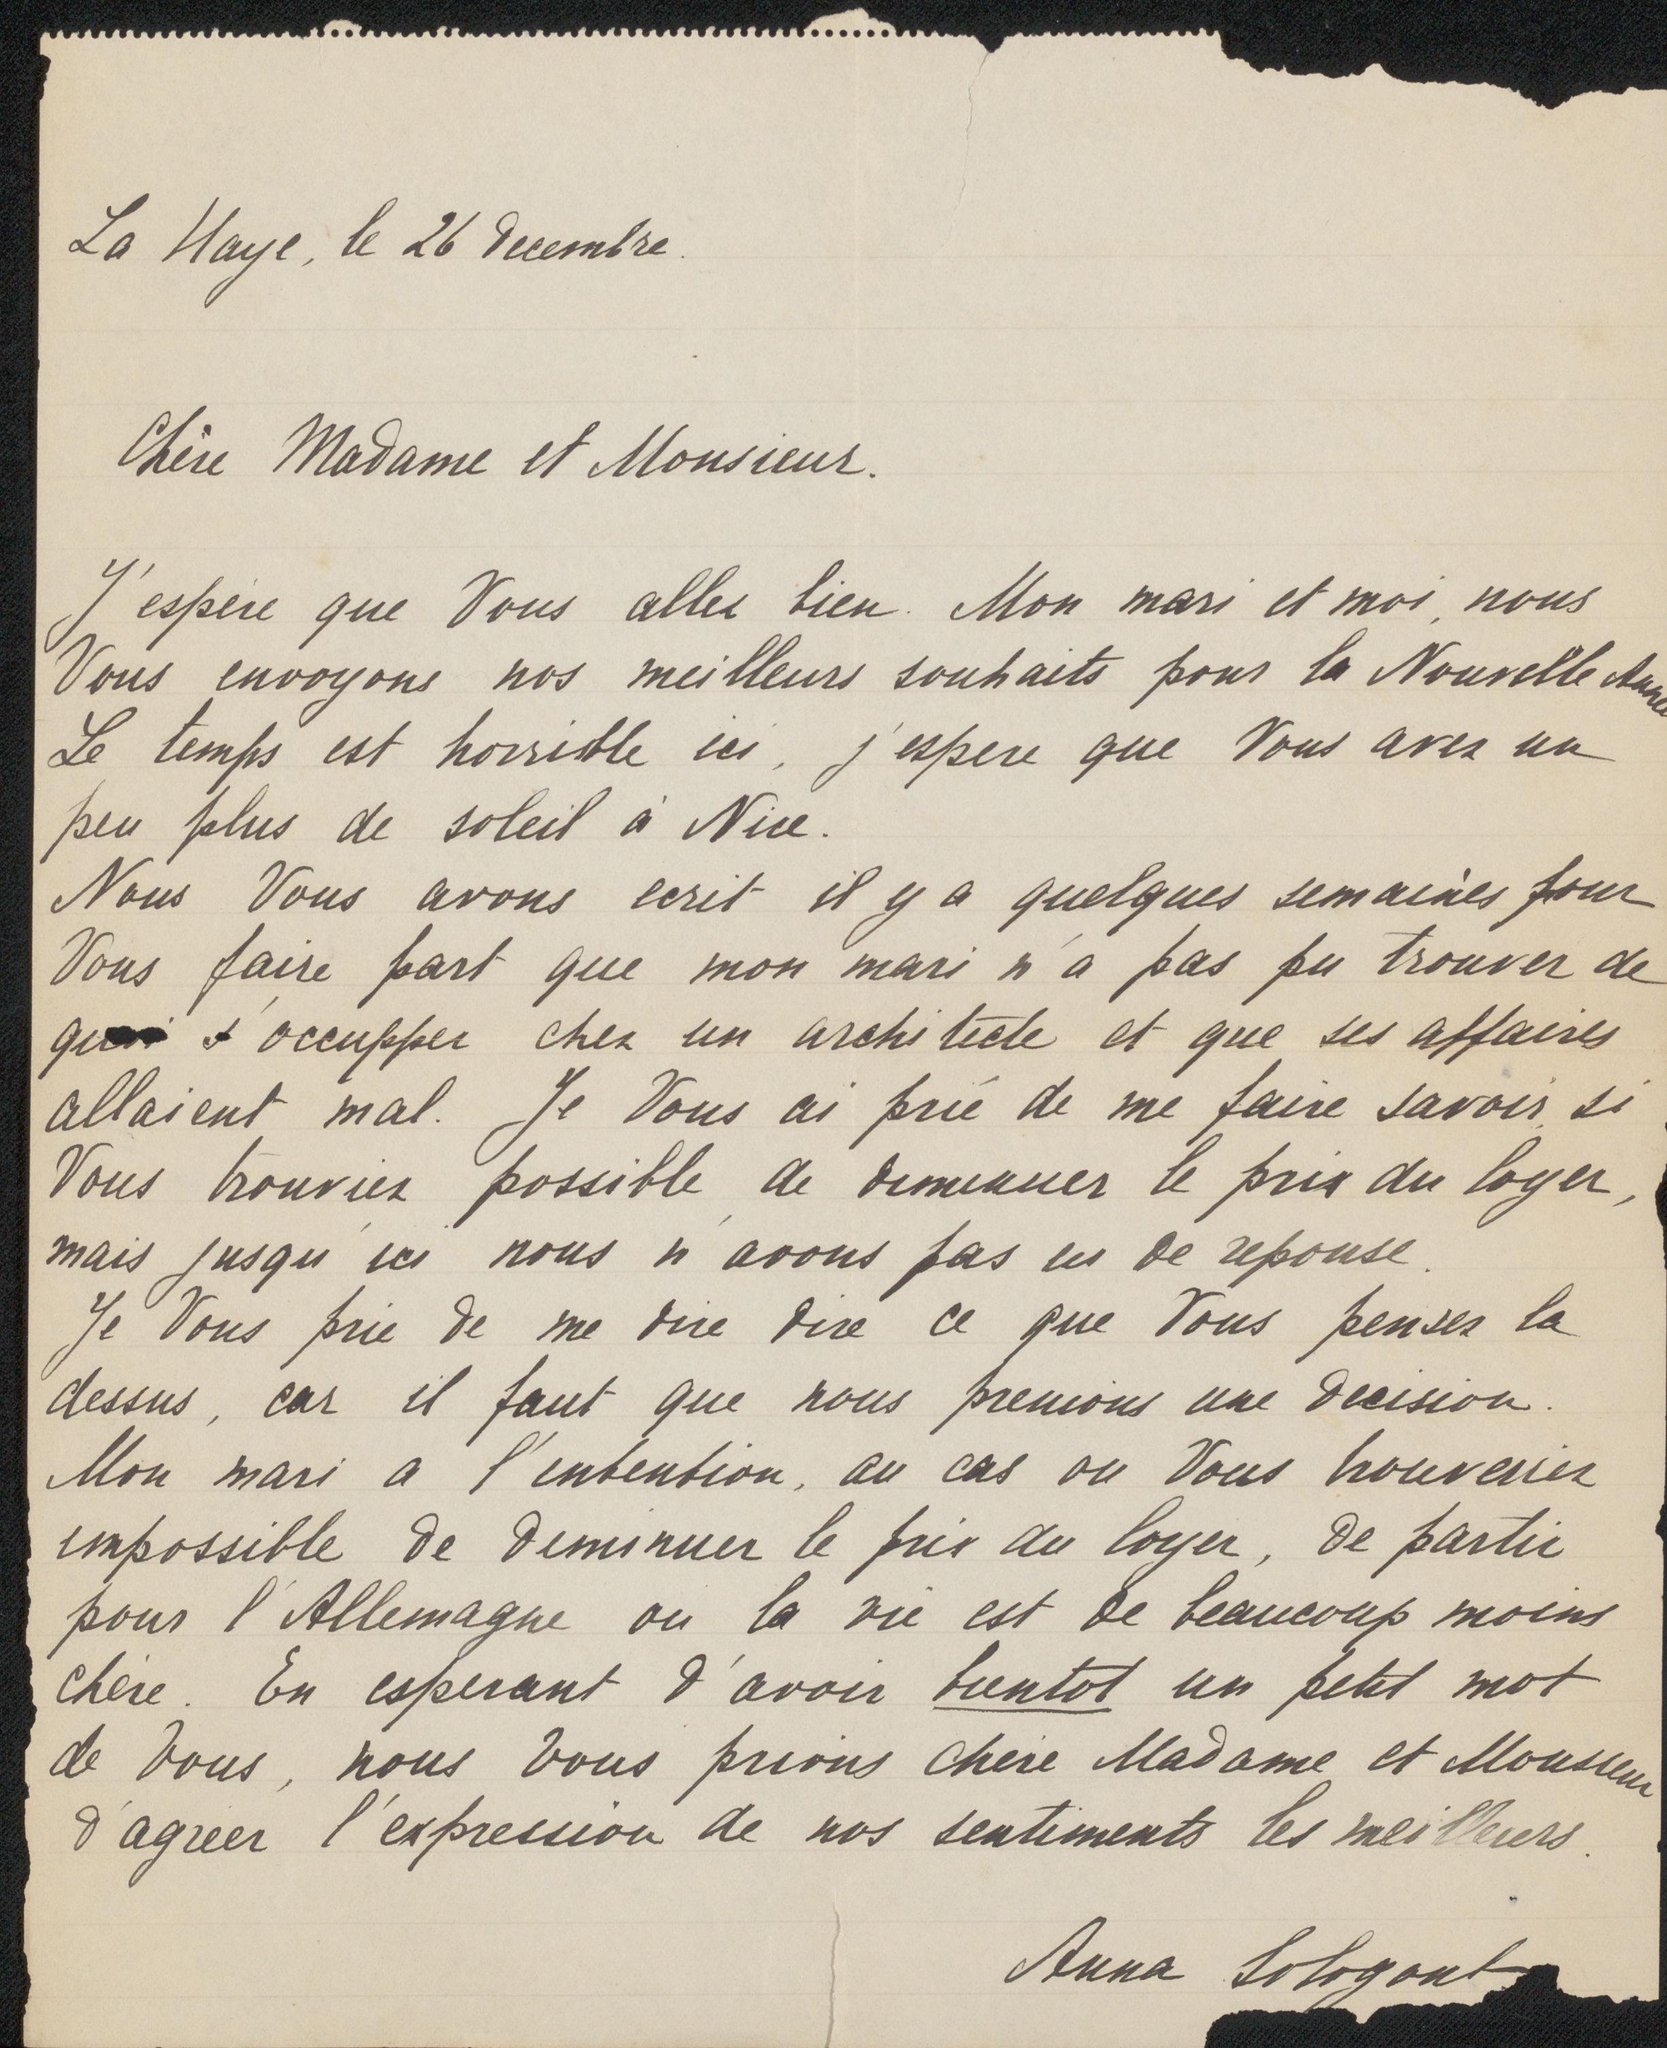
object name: letter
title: Brief aan Henriette Wilhelmina van Baak en Philip Zilcken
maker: anna sologoub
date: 1921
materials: ink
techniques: pen, writing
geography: the hague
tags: henriette wilhelmina van baak, leonid sologoub, the hague, painter, draughtsman, philip zilcken, architecture, germany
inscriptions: collector's mark: ‘RPK’